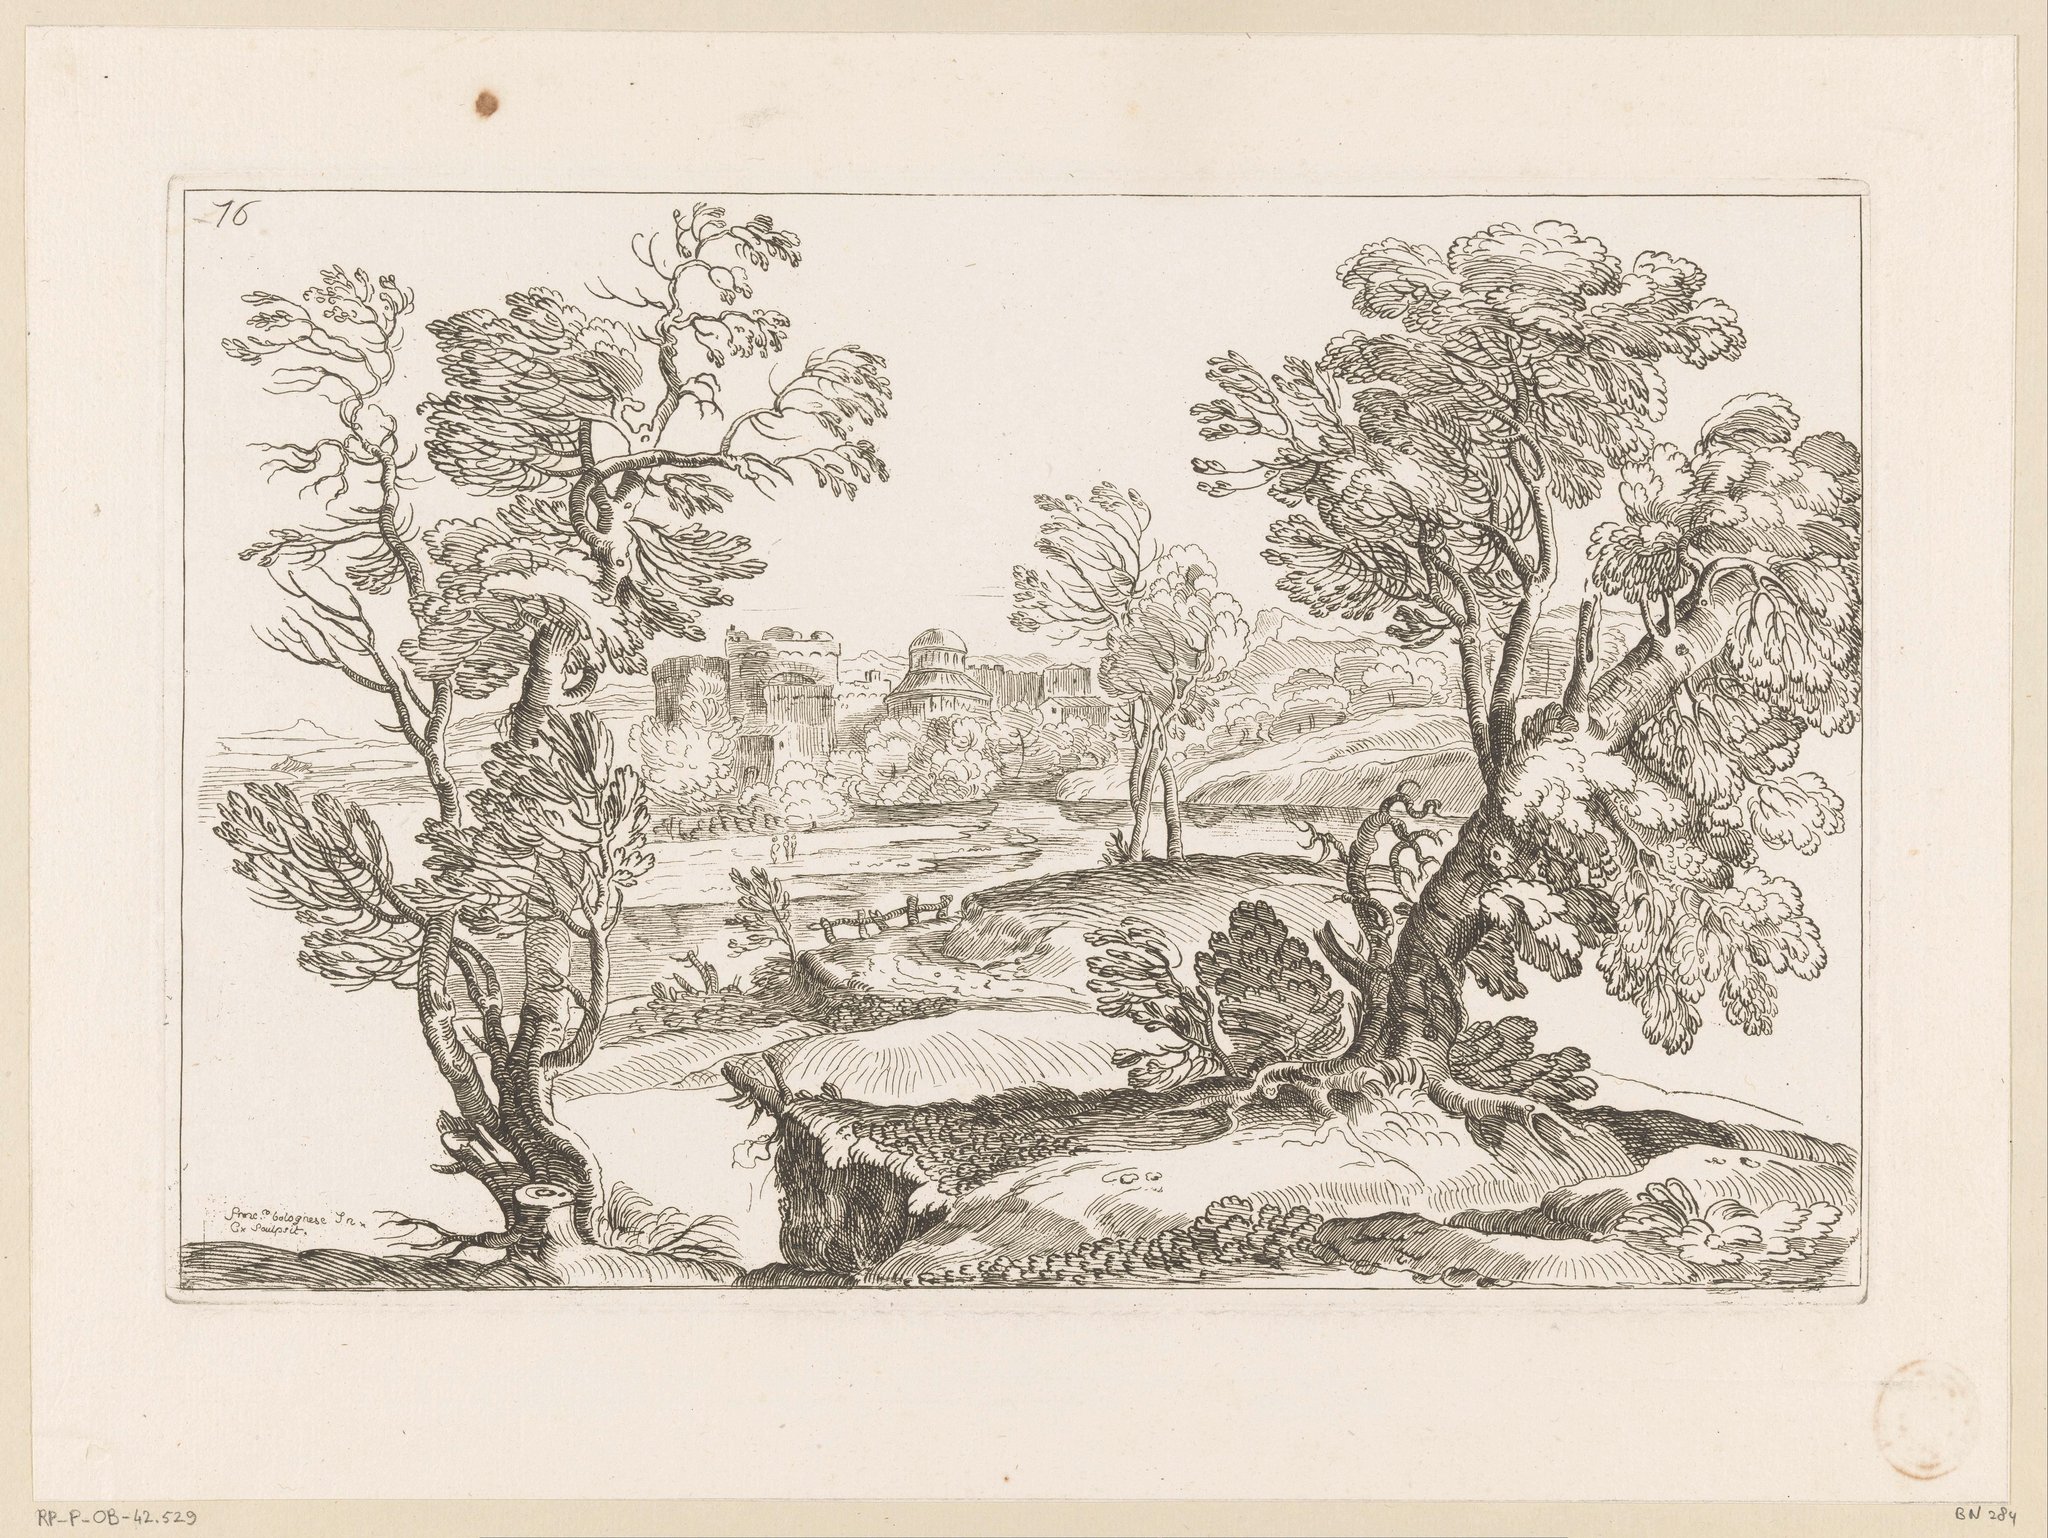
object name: print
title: Landschap met rivier en bomen, met op achtergrond een vestingstad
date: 1702-1765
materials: paper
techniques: etching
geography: france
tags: trees, landscapes - hh - ideal landscapes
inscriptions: collector's mark: Lugt 240